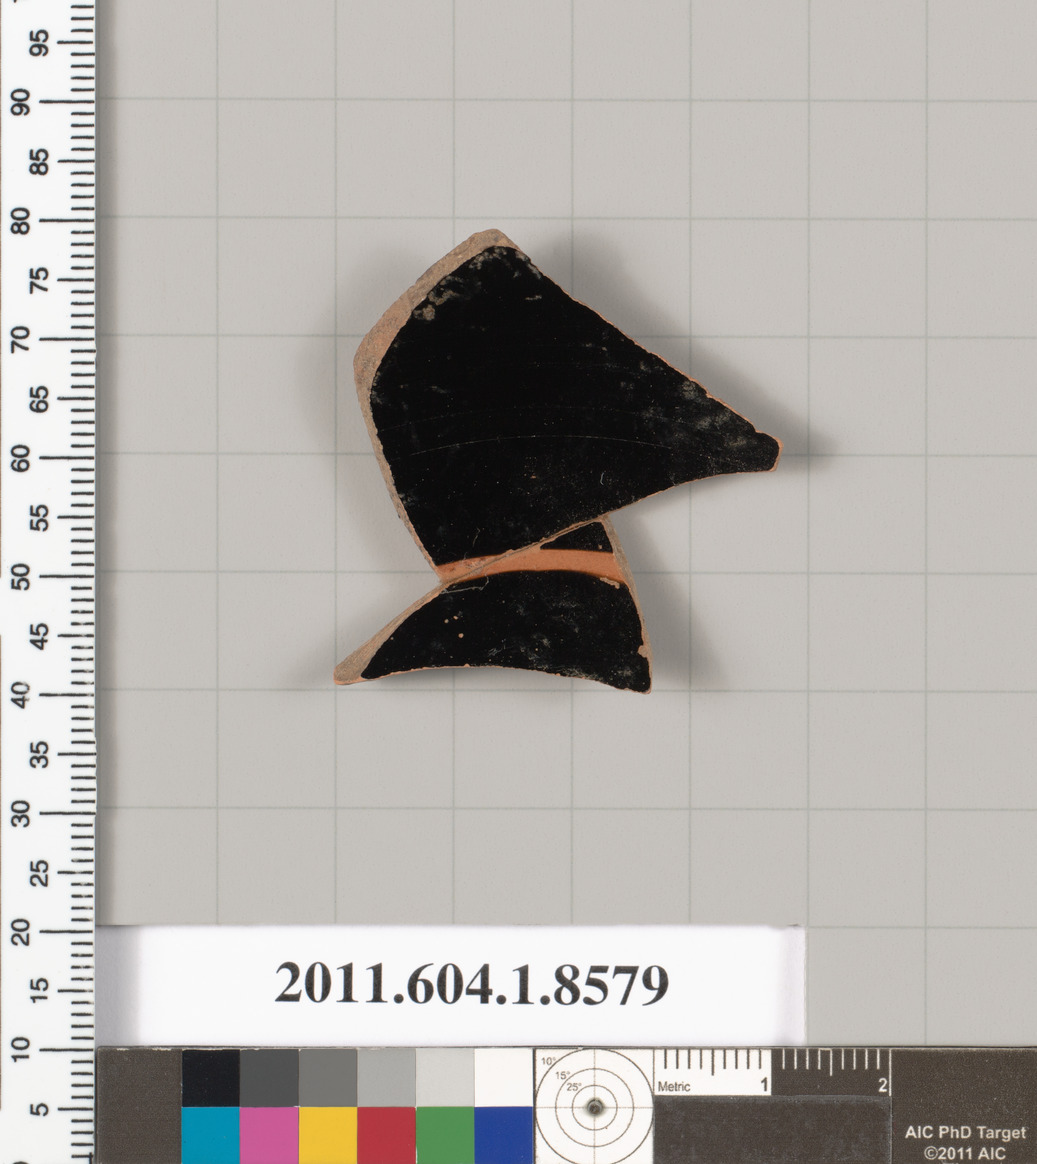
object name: kylix fragment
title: Terracotta fragment of a stemless kylix (drinking cup)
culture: greek, attic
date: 475-451 BCE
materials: terracotta